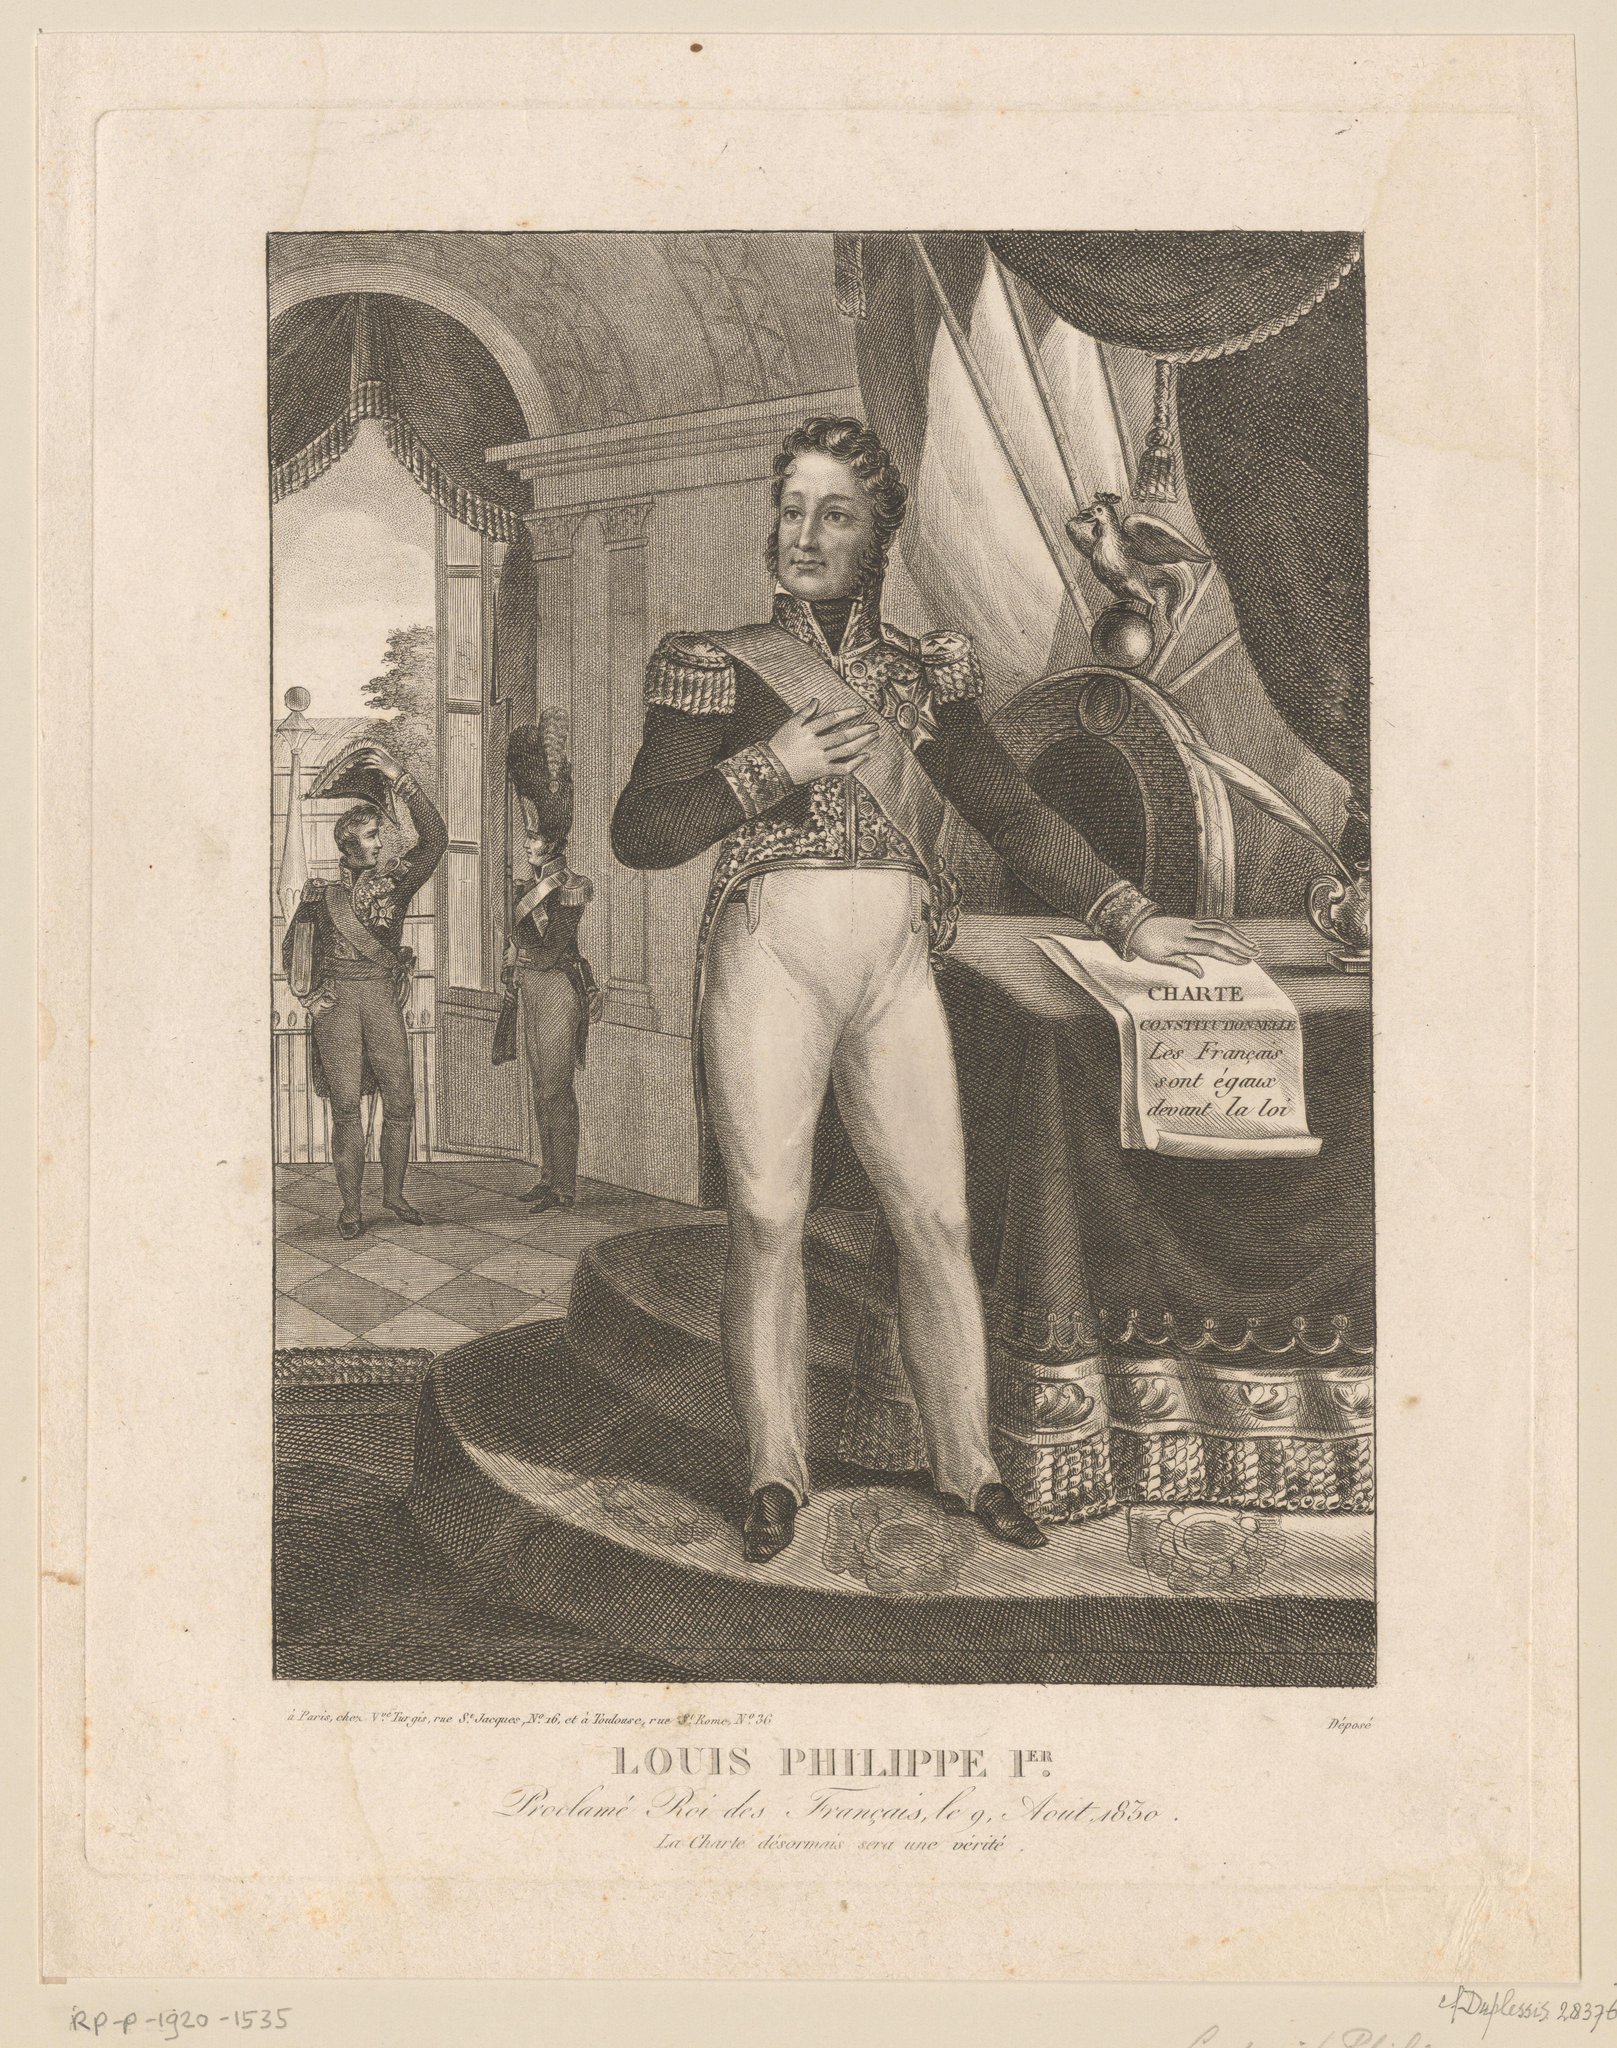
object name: print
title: Portret van Lodewijk Filips I van Frankrijk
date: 1830-1846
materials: paper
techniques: engraving, etching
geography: france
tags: lodewijk filips i (koning van frankrijk), writing-table, writing-desk, historical persons, (military) uniforms, king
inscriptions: : ‘Déposé’, number: ‘1923’, collector's mark: Lugt 2228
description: Portret ten voeten uit in een interieur. Zijn hand rust op de Charte de 1830.